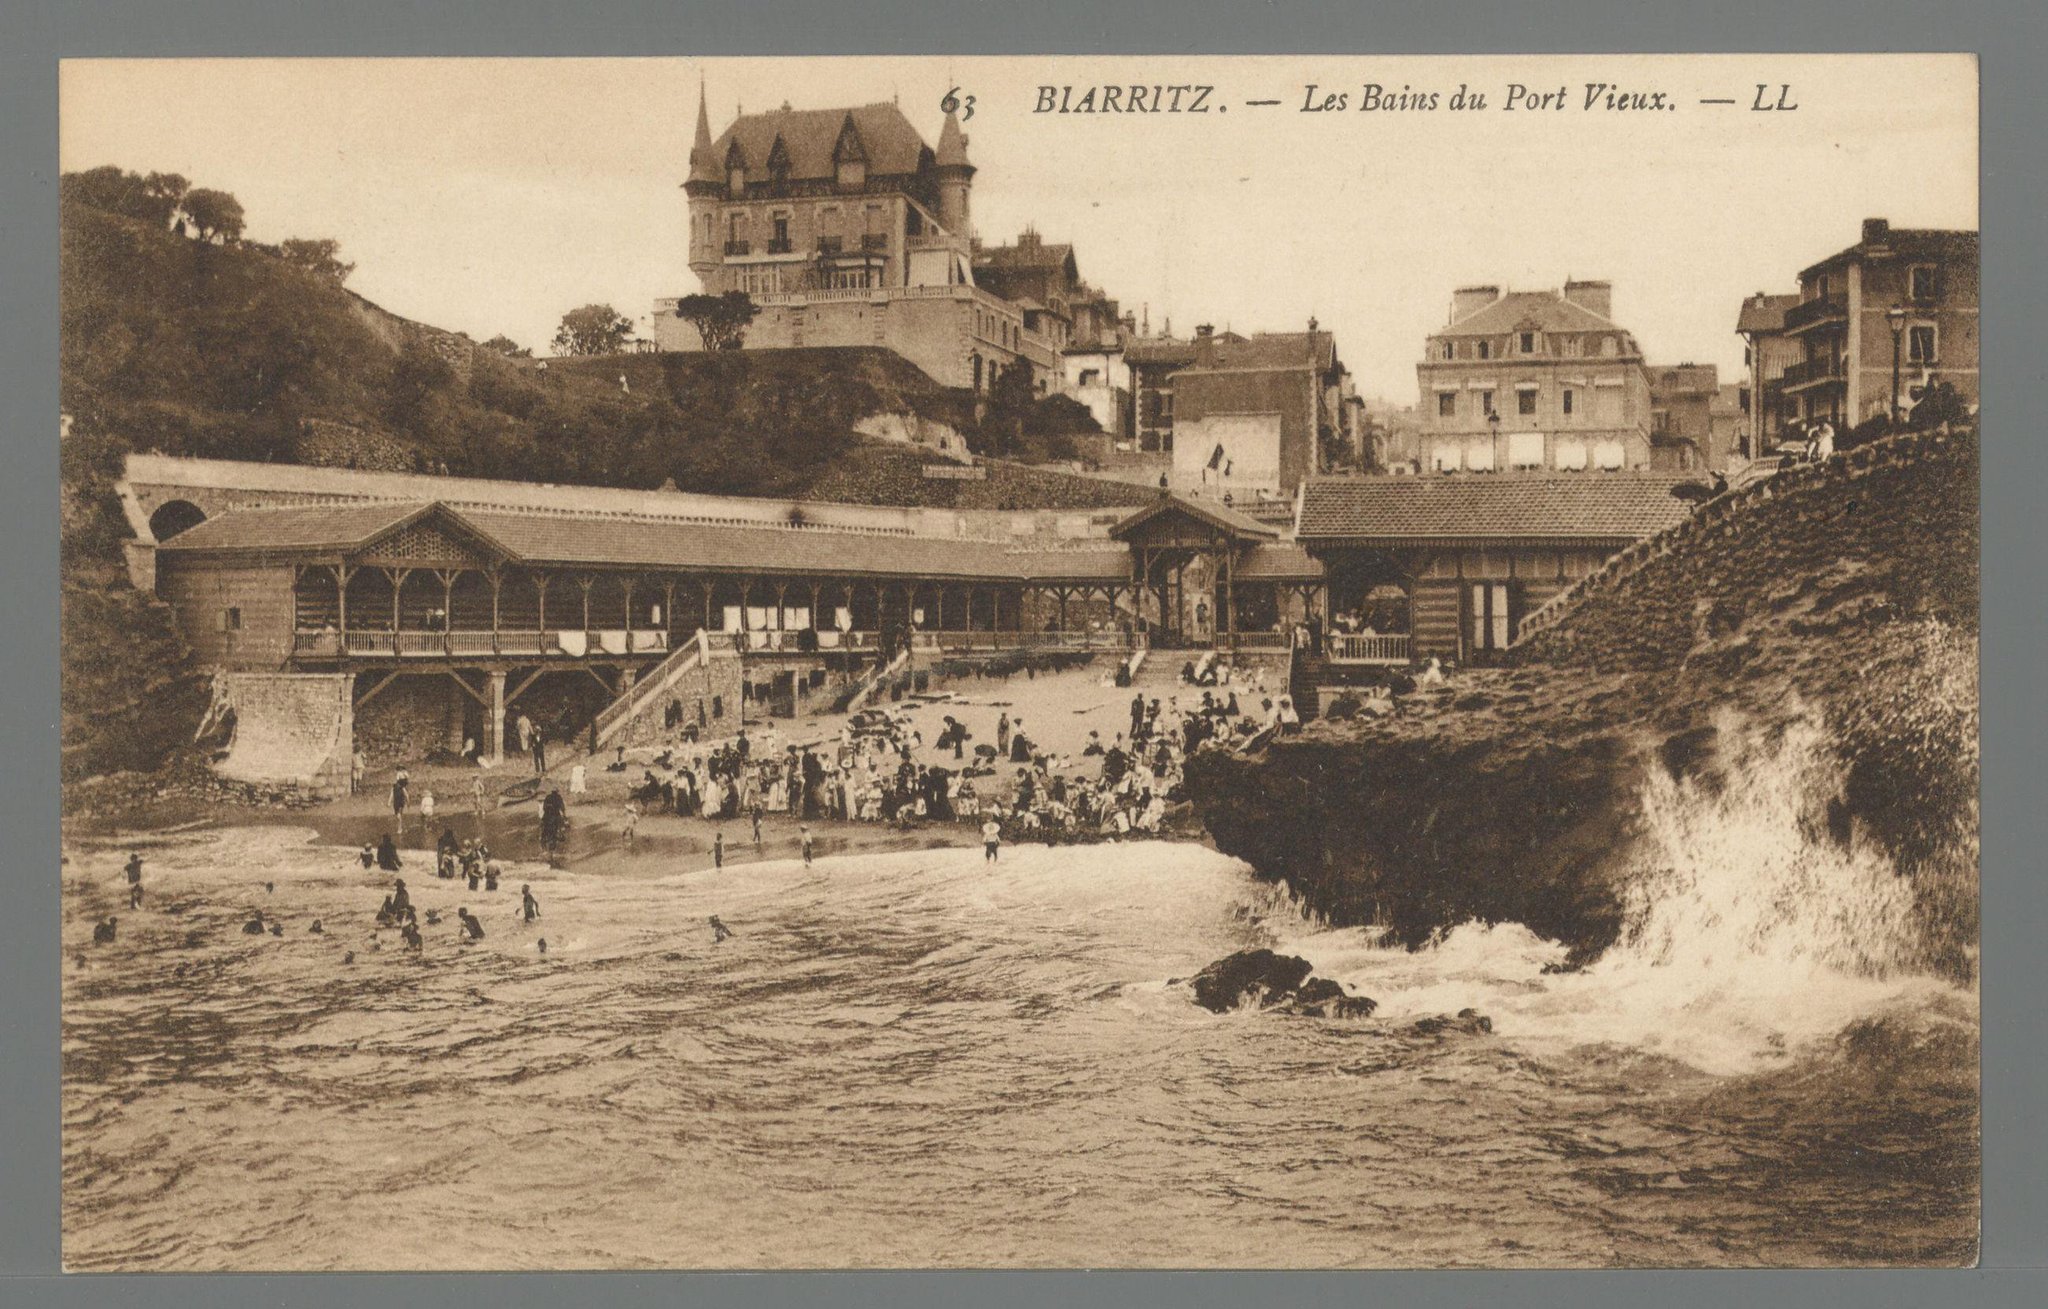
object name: ansichtkaart, prentbriefkaart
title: Biarritz. Les Bains du Port Vieux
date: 1903-1920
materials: cardboard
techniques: photograph, writing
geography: paris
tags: urban housing, in or beside the water (on the beach)